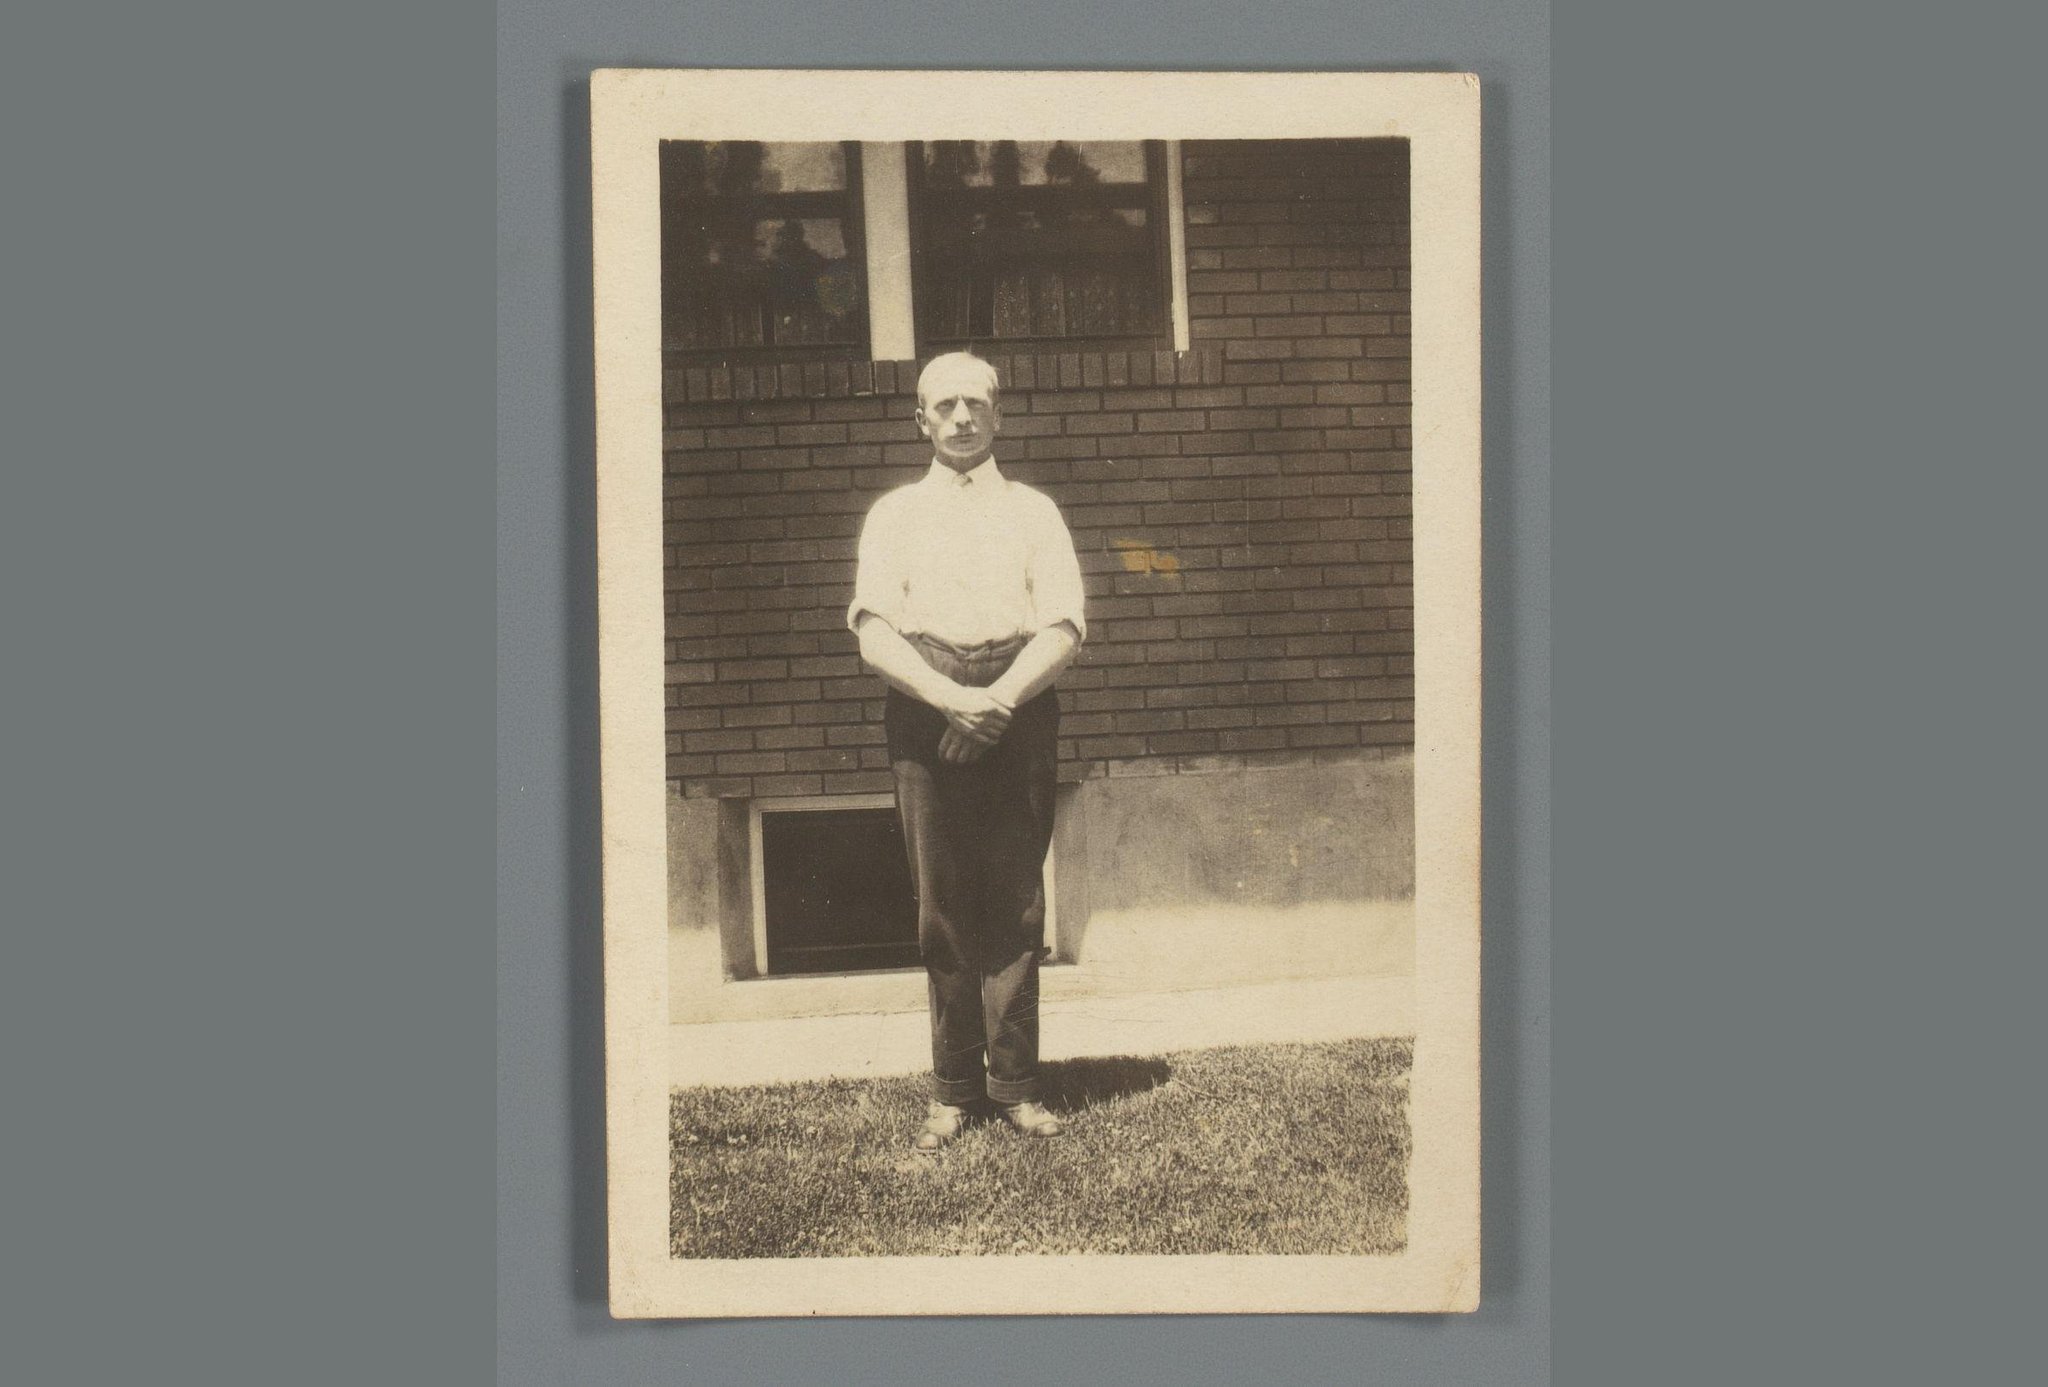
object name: photograph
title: Portret van een onbekende man staand voor een huis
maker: Anonymous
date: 1930-1960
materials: paper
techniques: gelatin silver print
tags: historical persons not known by name